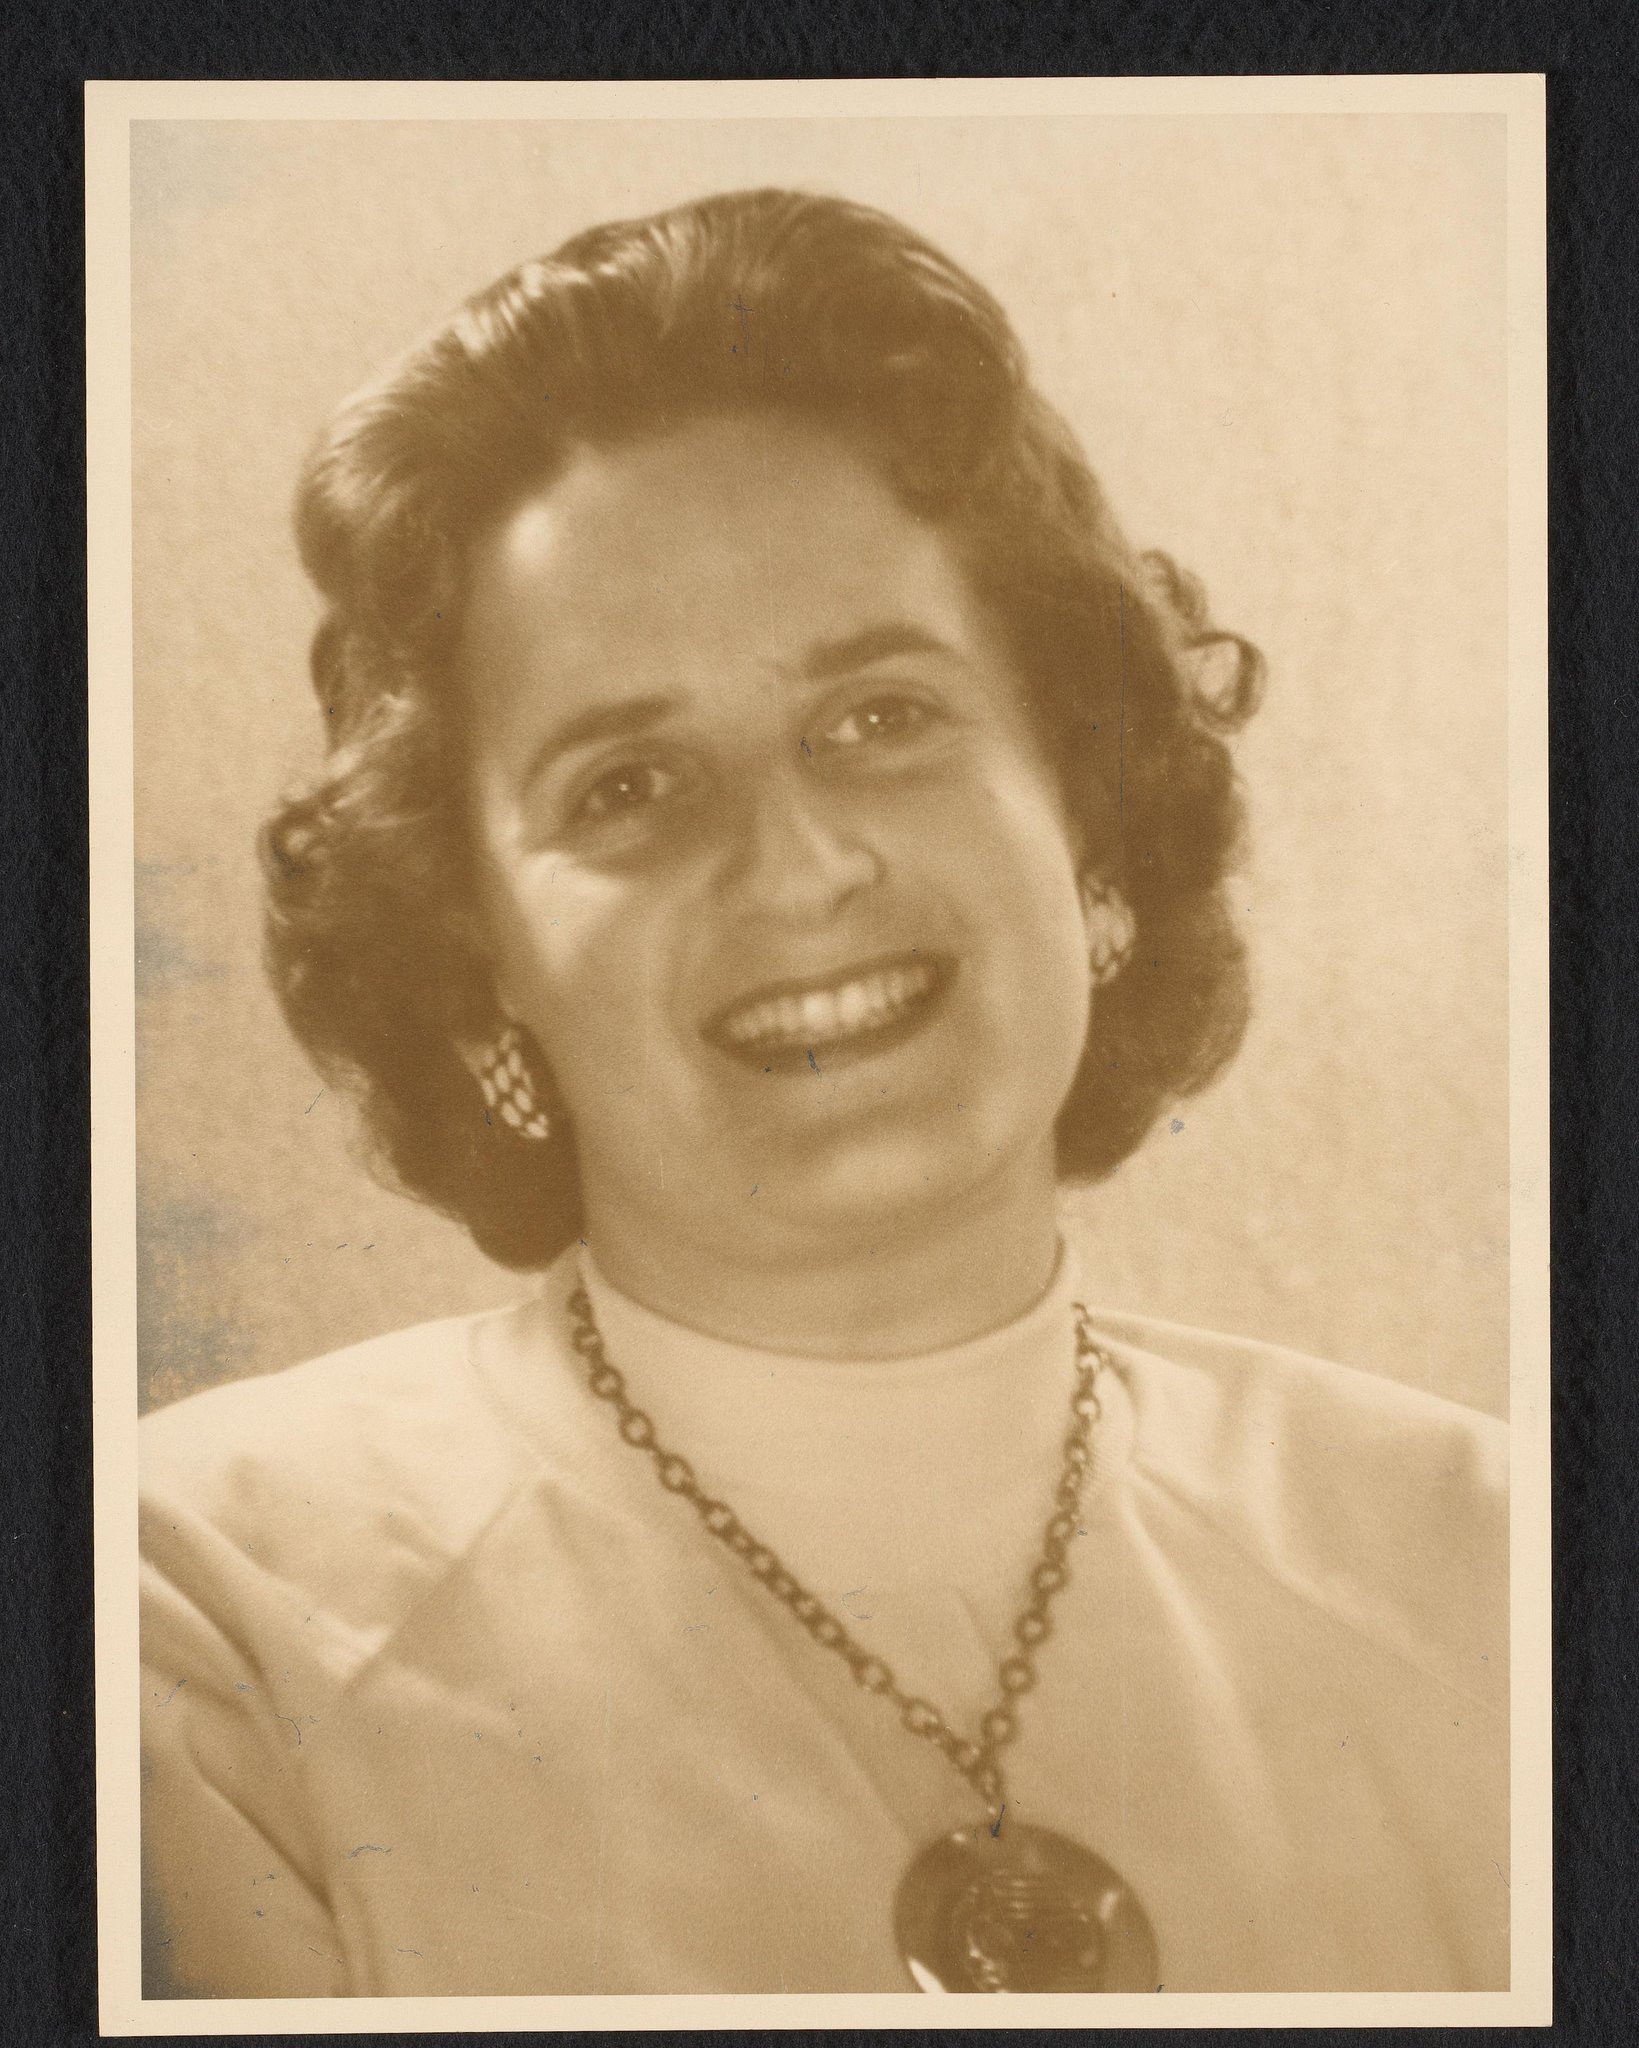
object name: photograph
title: Portret van Isabel Wachenheimer, in Duitsland of de Verenigde Staten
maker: Anonymous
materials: paper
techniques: gelatin silver print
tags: leiden, isabel wachenheimer-elon, historical persons - bb - woman